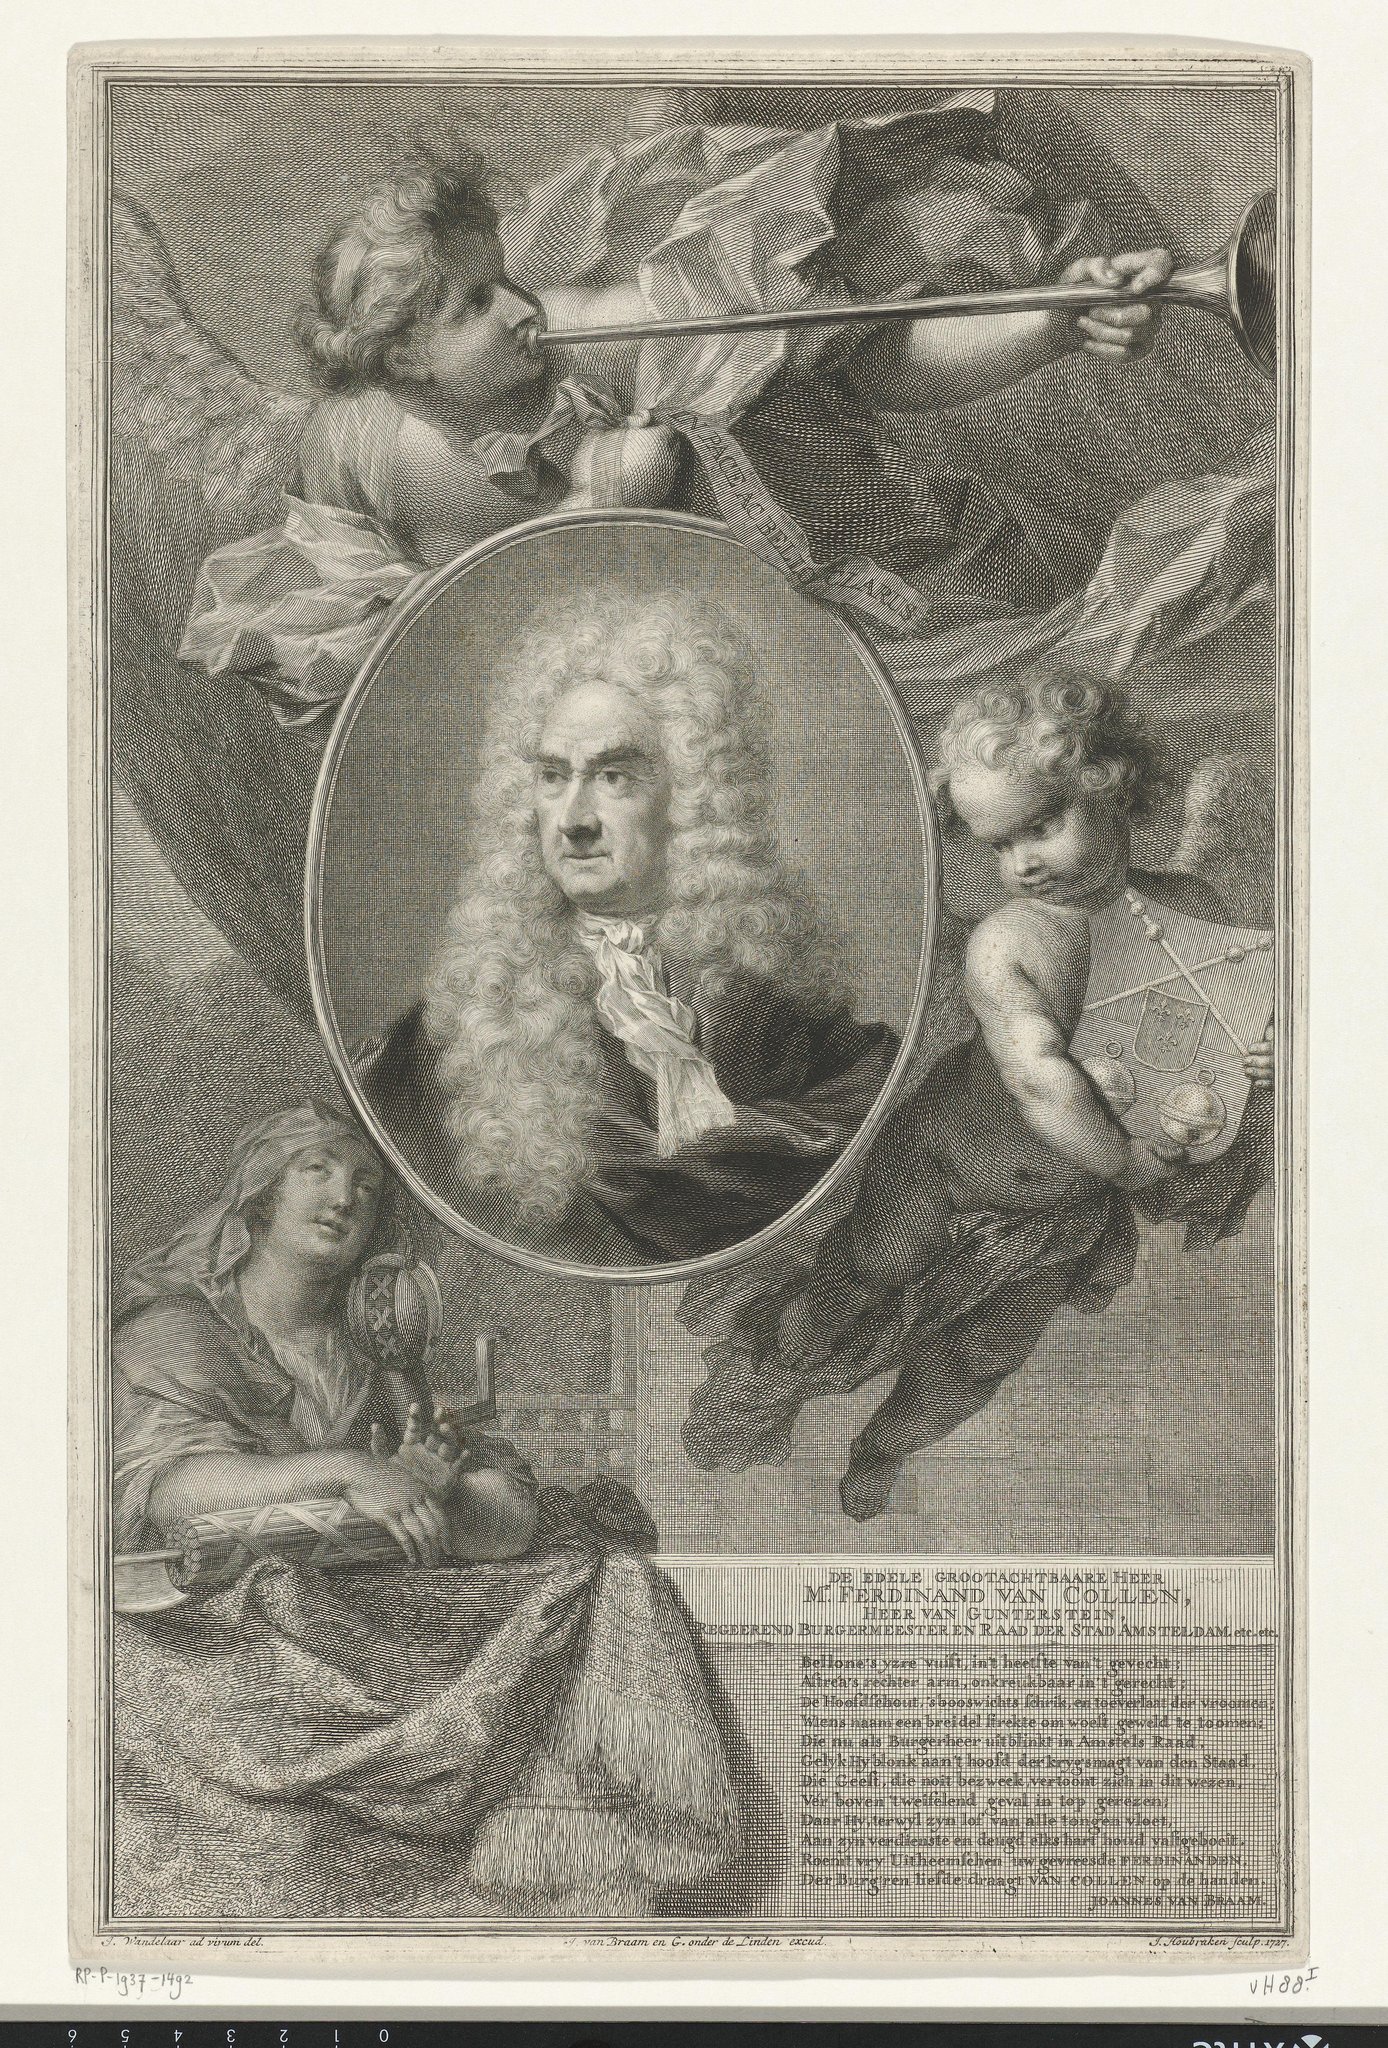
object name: print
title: Portret van Ferdinand van Collen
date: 1727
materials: paper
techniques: engraving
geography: amsterdam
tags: ferdinand van collen, horn, trumpet, cornet, trombone, tuba, angels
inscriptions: collector's mark: Lugt 2228, collector's mark: Lugt 2760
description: Buste van Ferdinand van Collen in een ovaal medaillon. Linksonder een allegorische vrouwenfiguur die de stad Amsterdam voorstelt, rechts een putto met het wapen van Van Collen en linksboven een engel met trompet. Rechtsonder zijn naam en gegevens in vier regels in het Nederlands met daaronder een twaalfregelig vers in het Nederlands.